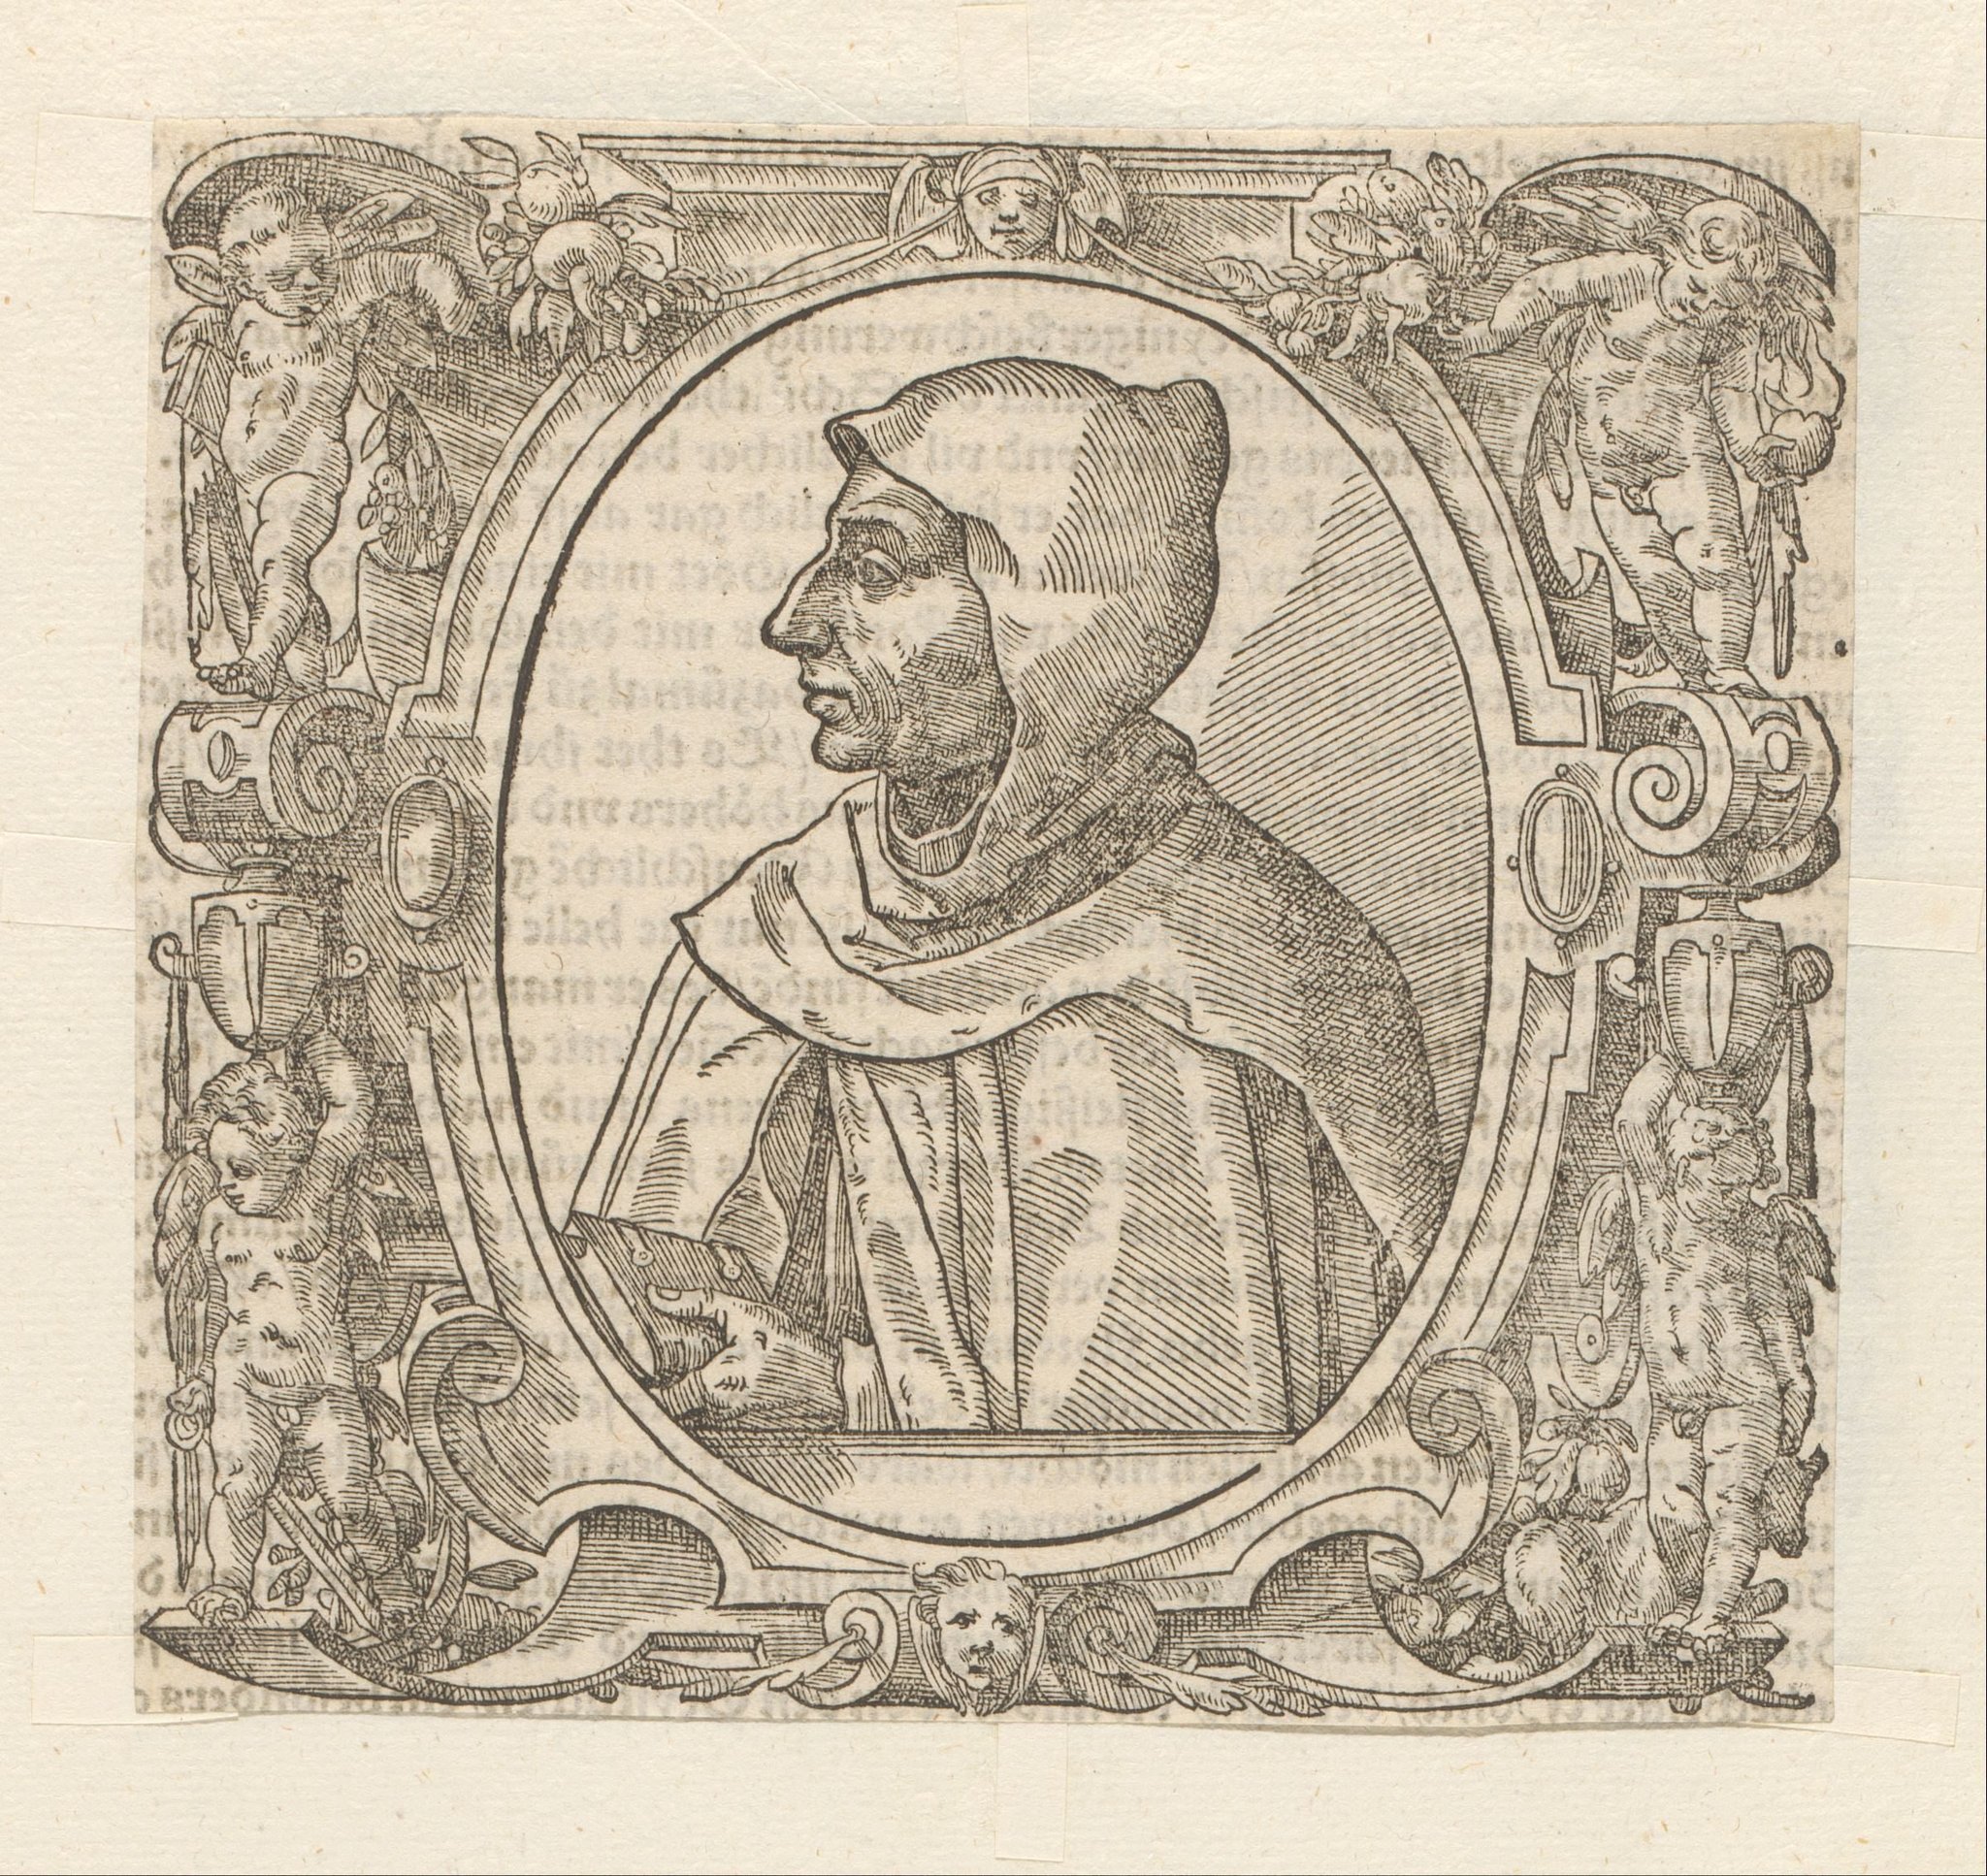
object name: book illustration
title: Portret van Girolamo Savonarola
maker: Anonymous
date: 1549-1572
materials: paper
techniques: letterpress printing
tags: priest, politician, historical persons, politician, e.g. party leader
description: Prent is gebruikt in: Rabus, Ludovicus. Historien der Martyrer (...). Straatsburg: Josias Rihel, 1572.